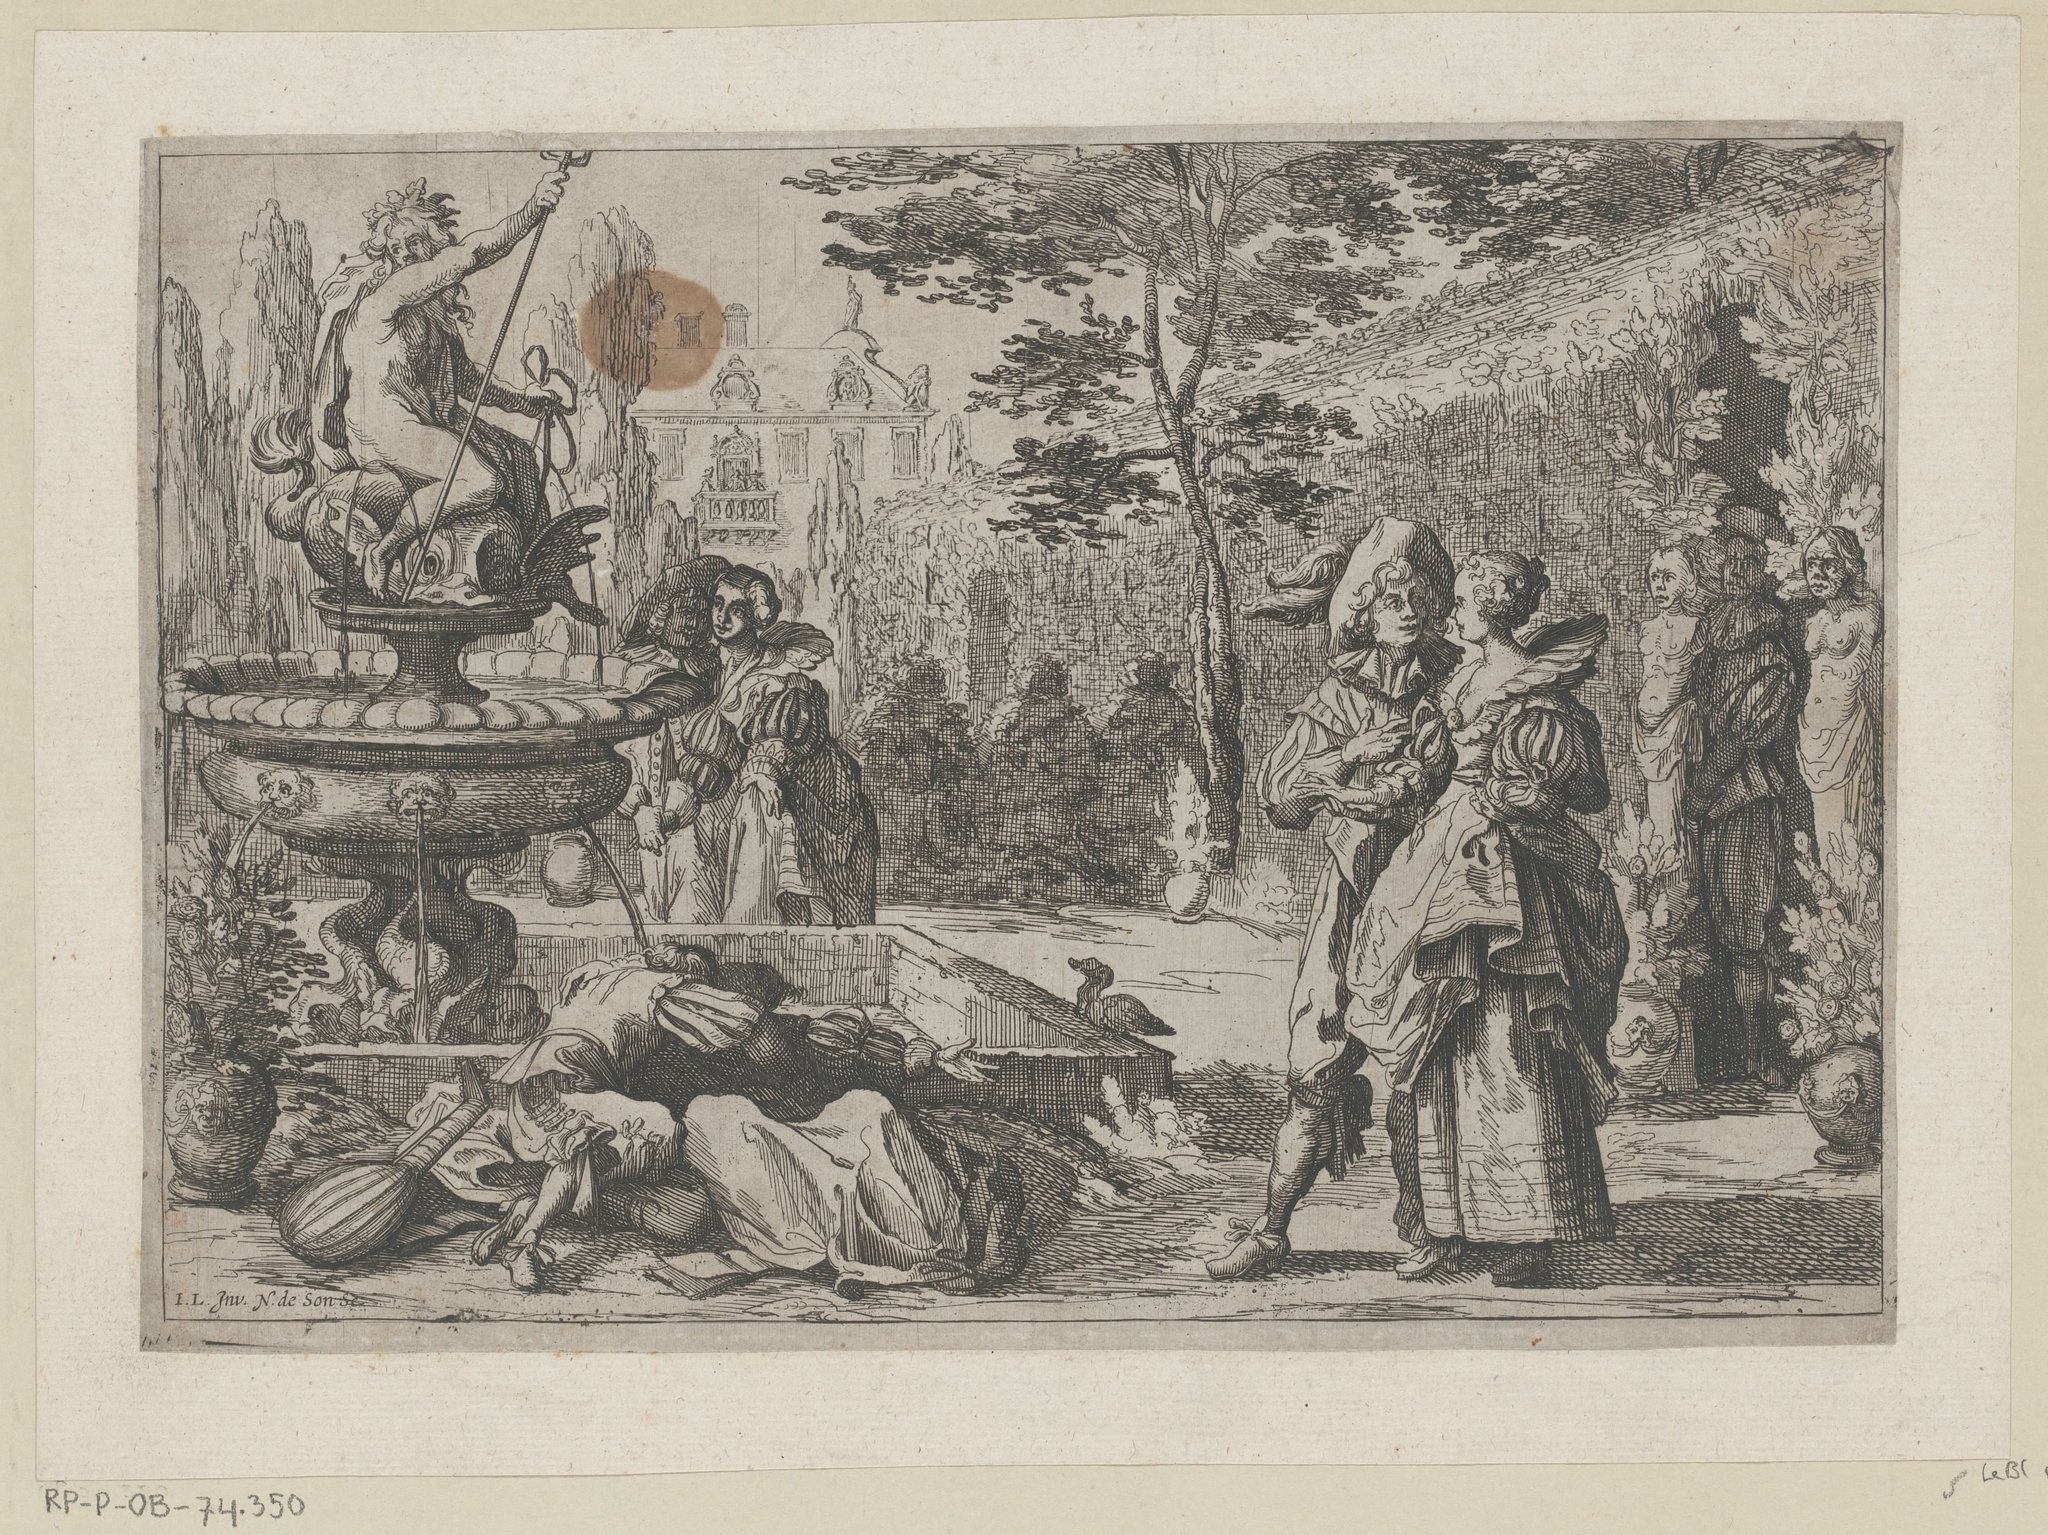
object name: print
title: Gezicht op tuin met Neptunusfontein en verliefde paartjes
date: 1611-1650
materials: paper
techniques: etching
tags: (story of) neptune (poseidon), garden fountain, french or architectonic garden; formal garden, couple of lovers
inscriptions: collector's mark: Lugt 240